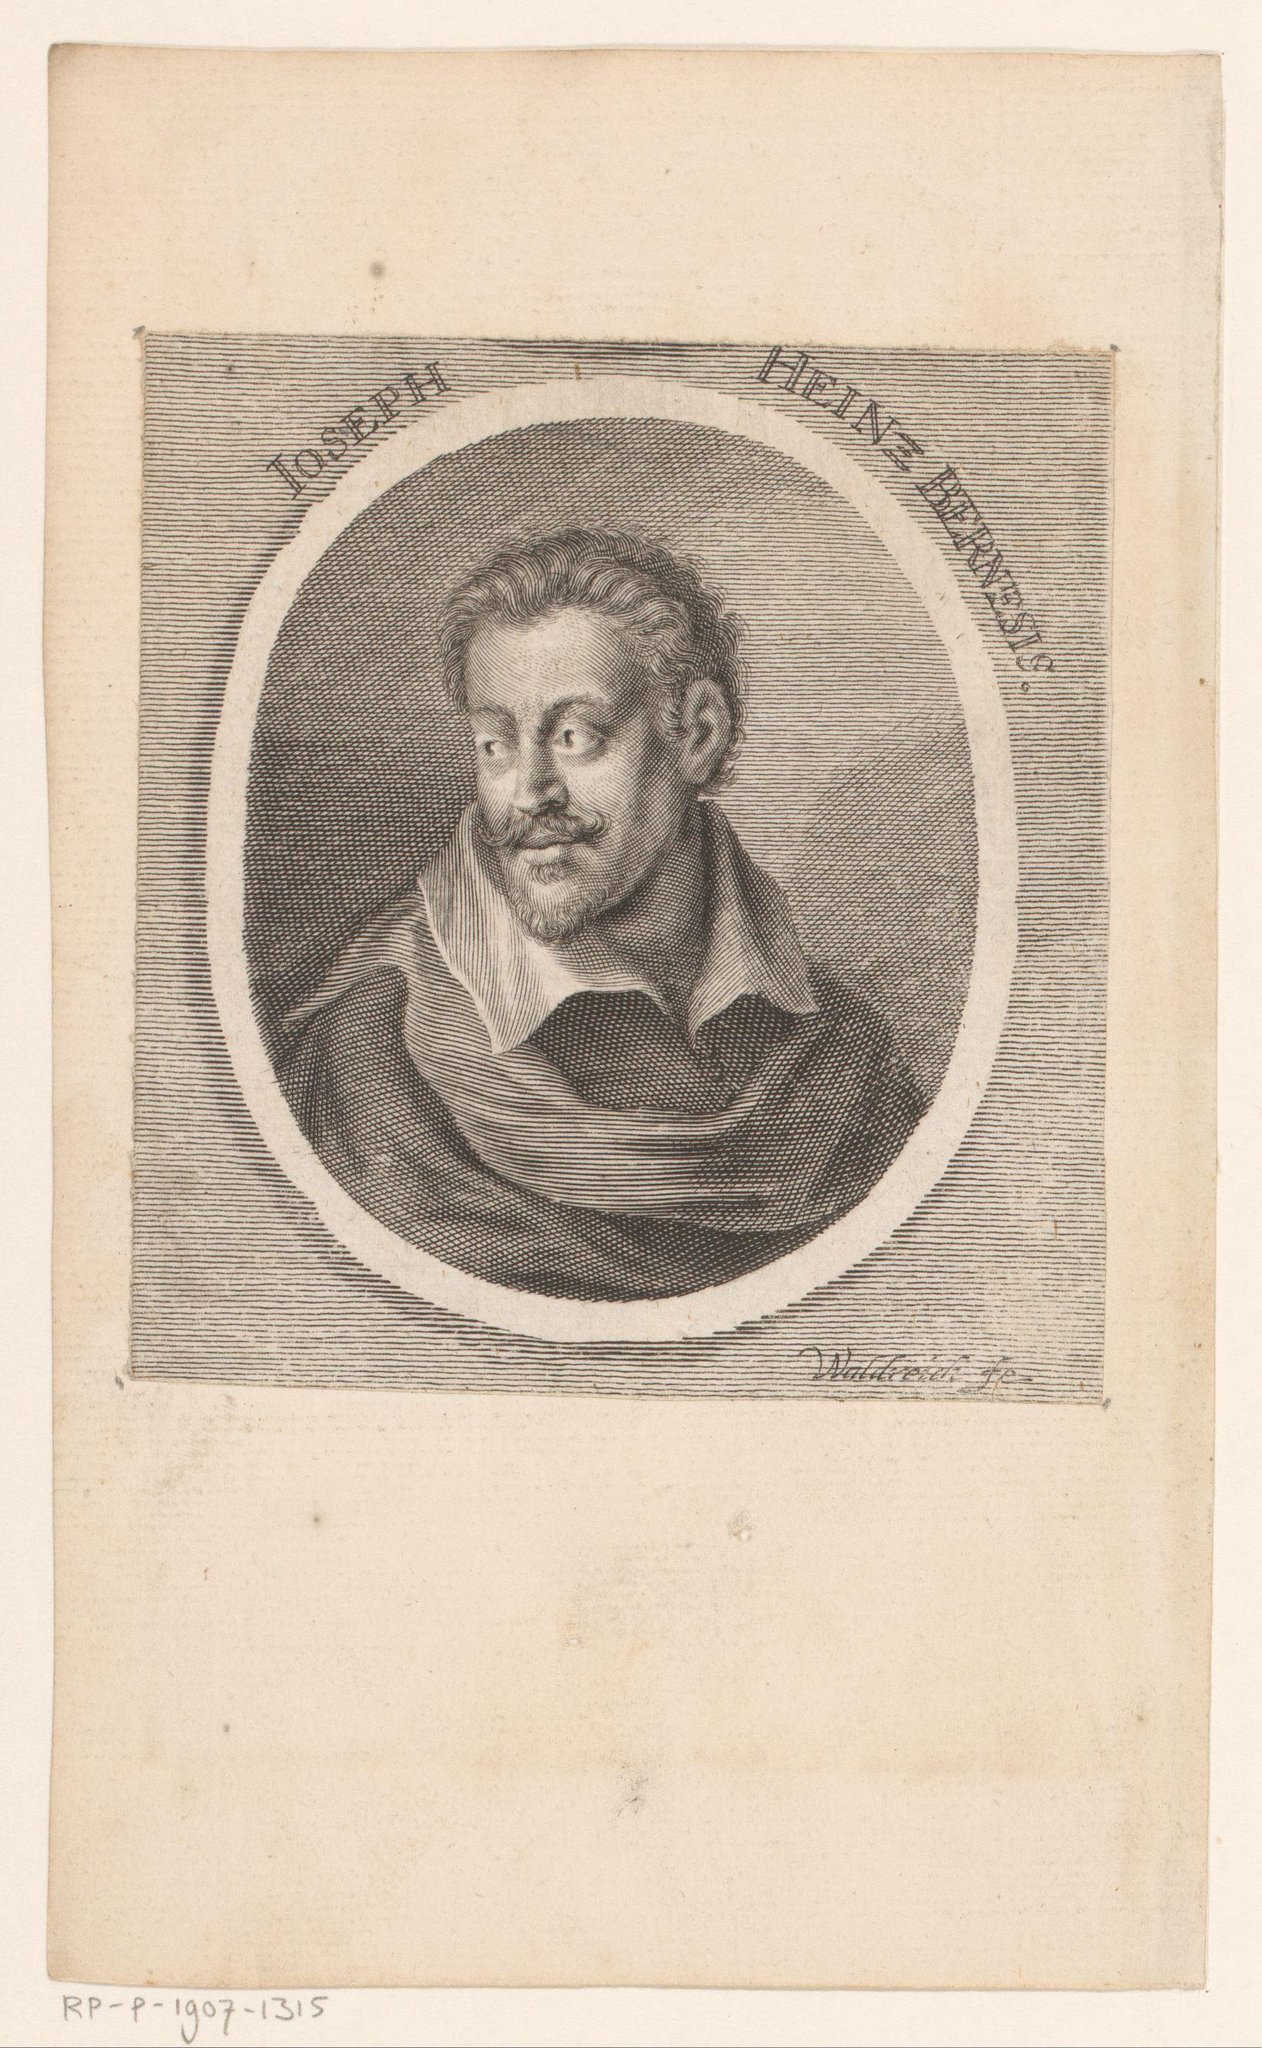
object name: print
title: Portret van Joseph I Heintz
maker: johann georg waldreich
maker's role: print maker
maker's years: -1680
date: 1675-1680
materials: paper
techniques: engraving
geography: nuremberg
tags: painter, draughtsman, joseph heintz (i), historical persons, portrait, self-portrait of artist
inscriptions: collector's mark: Lugt 2228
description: Fragment van een prent gebruikt voor: Sandrart, Joachim von. L'Academia Todesca della Architectura Scultura e Pittura oder Teutsche Academie der Edlen Bau-, Bild- und Mahlerey-Künste. Nürnberg: Neurenberg: 1675-1680. Afkomstig van een blad met zes kunstenaarsportretten, samen met de portretten van Giambologna, Pieter Brueghel I, Bartholomeus Spranger, Joos van Winghe en Hans von Aachen.